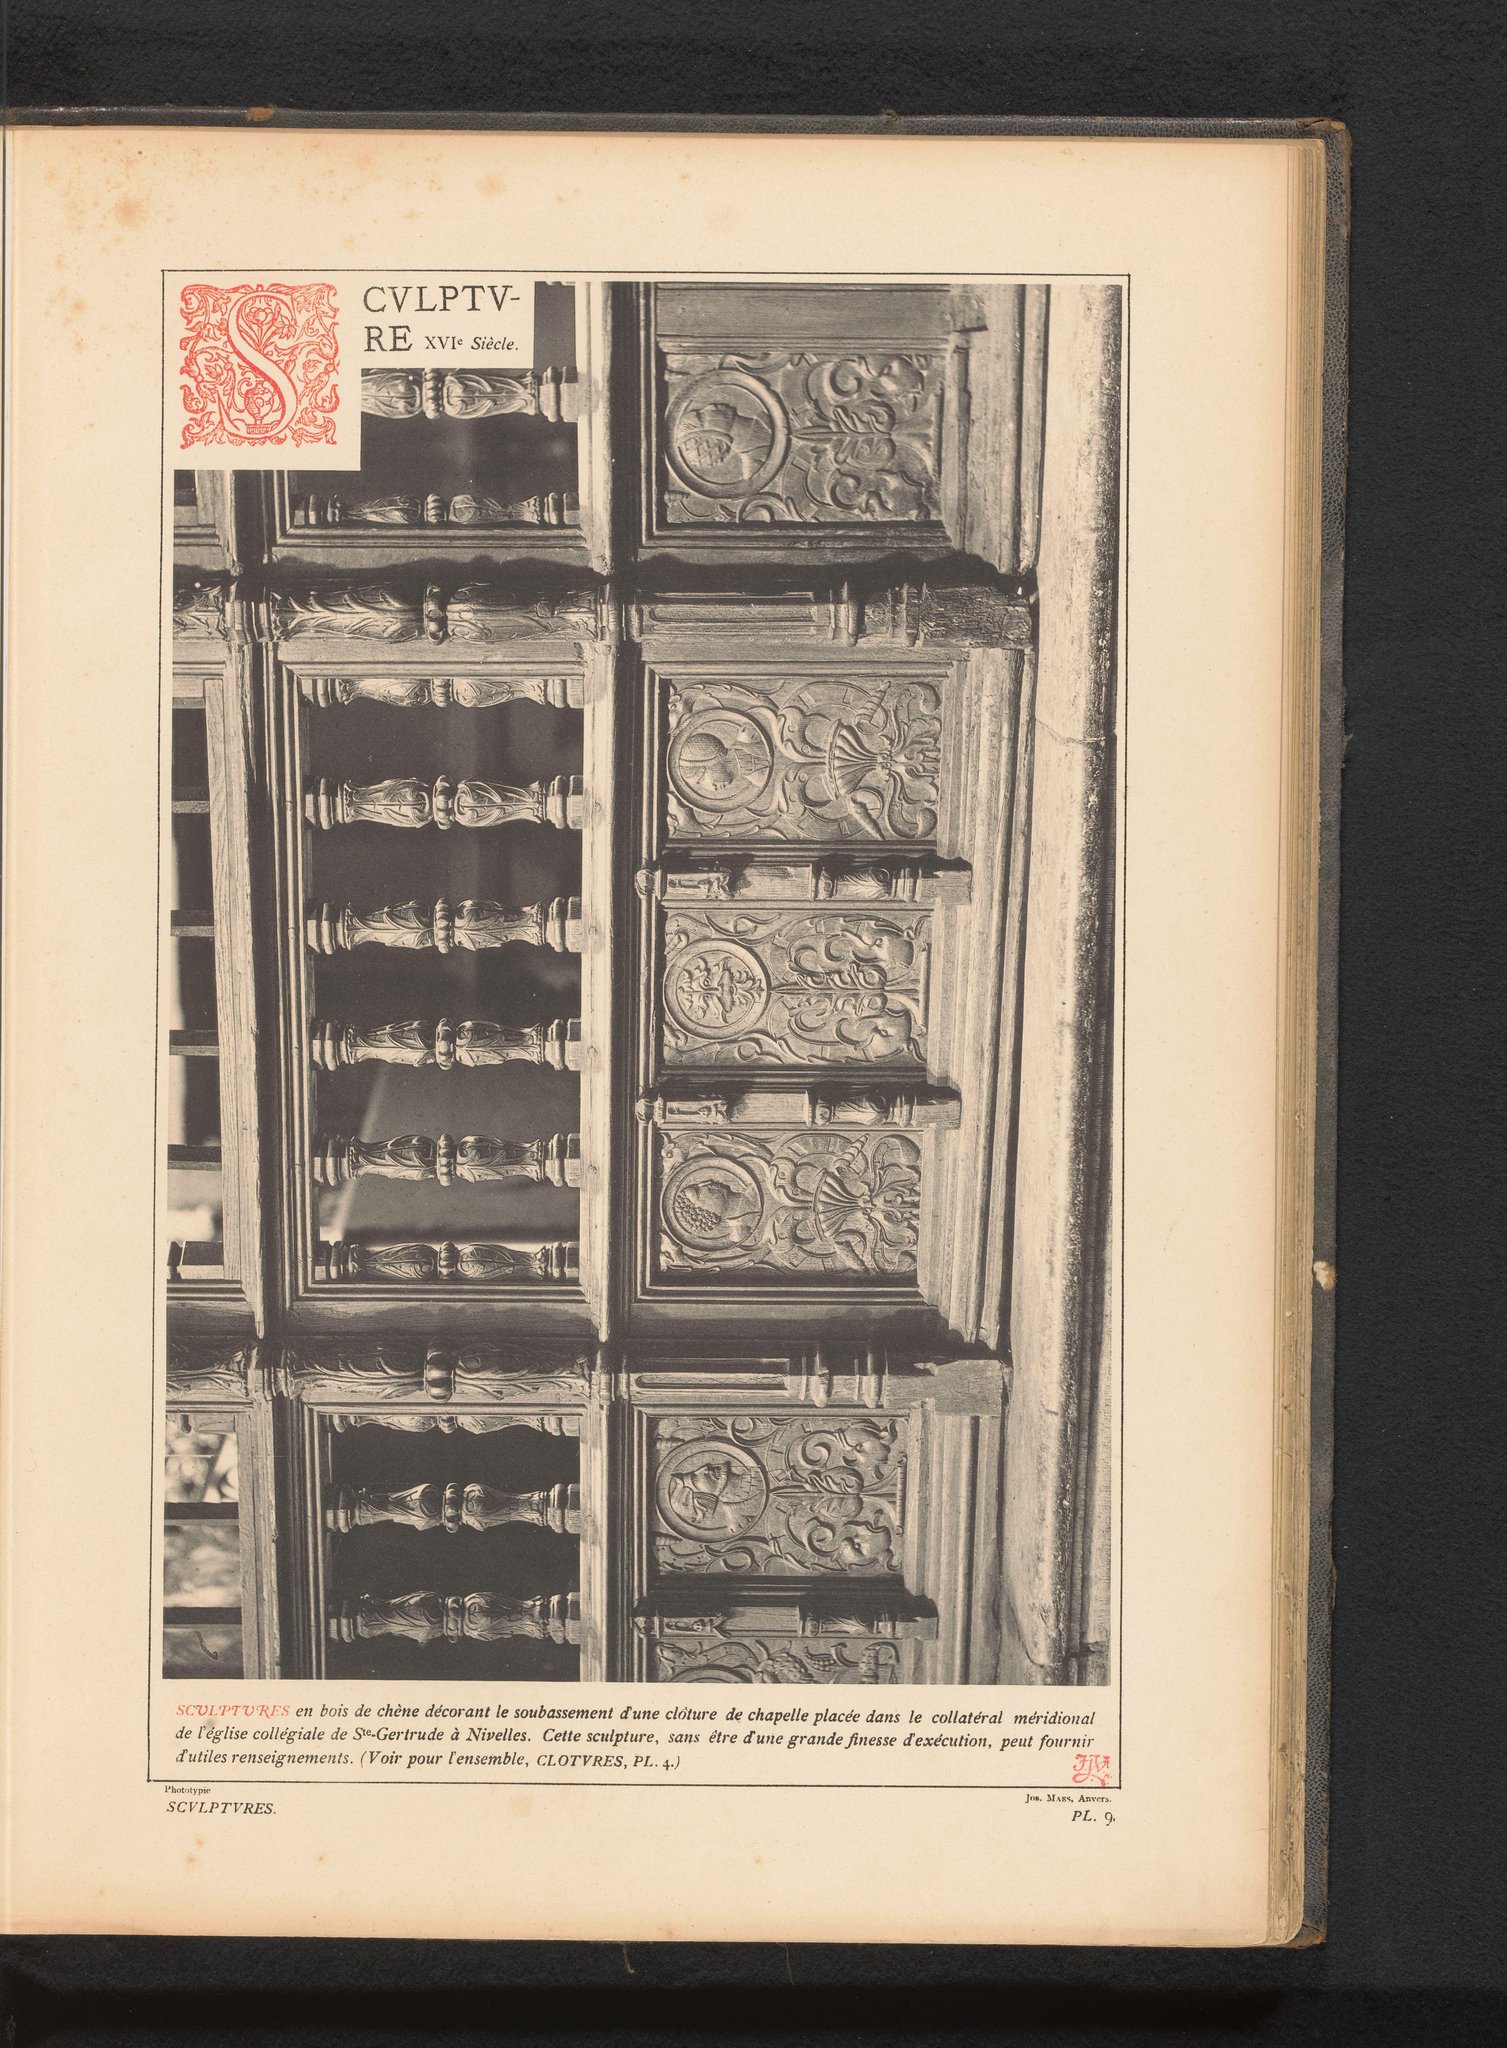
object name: page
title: Sculpture, XVIe Siècle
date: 1881-1889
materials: paper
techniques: photograph, photolithography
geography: nivelles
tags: sculpture, nivelles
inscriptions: inscription: ‘SCULPTURES en bois (...)’, monogram: ‘JJvY’, inscription: ‘SCULPTURES. PL. 9.’